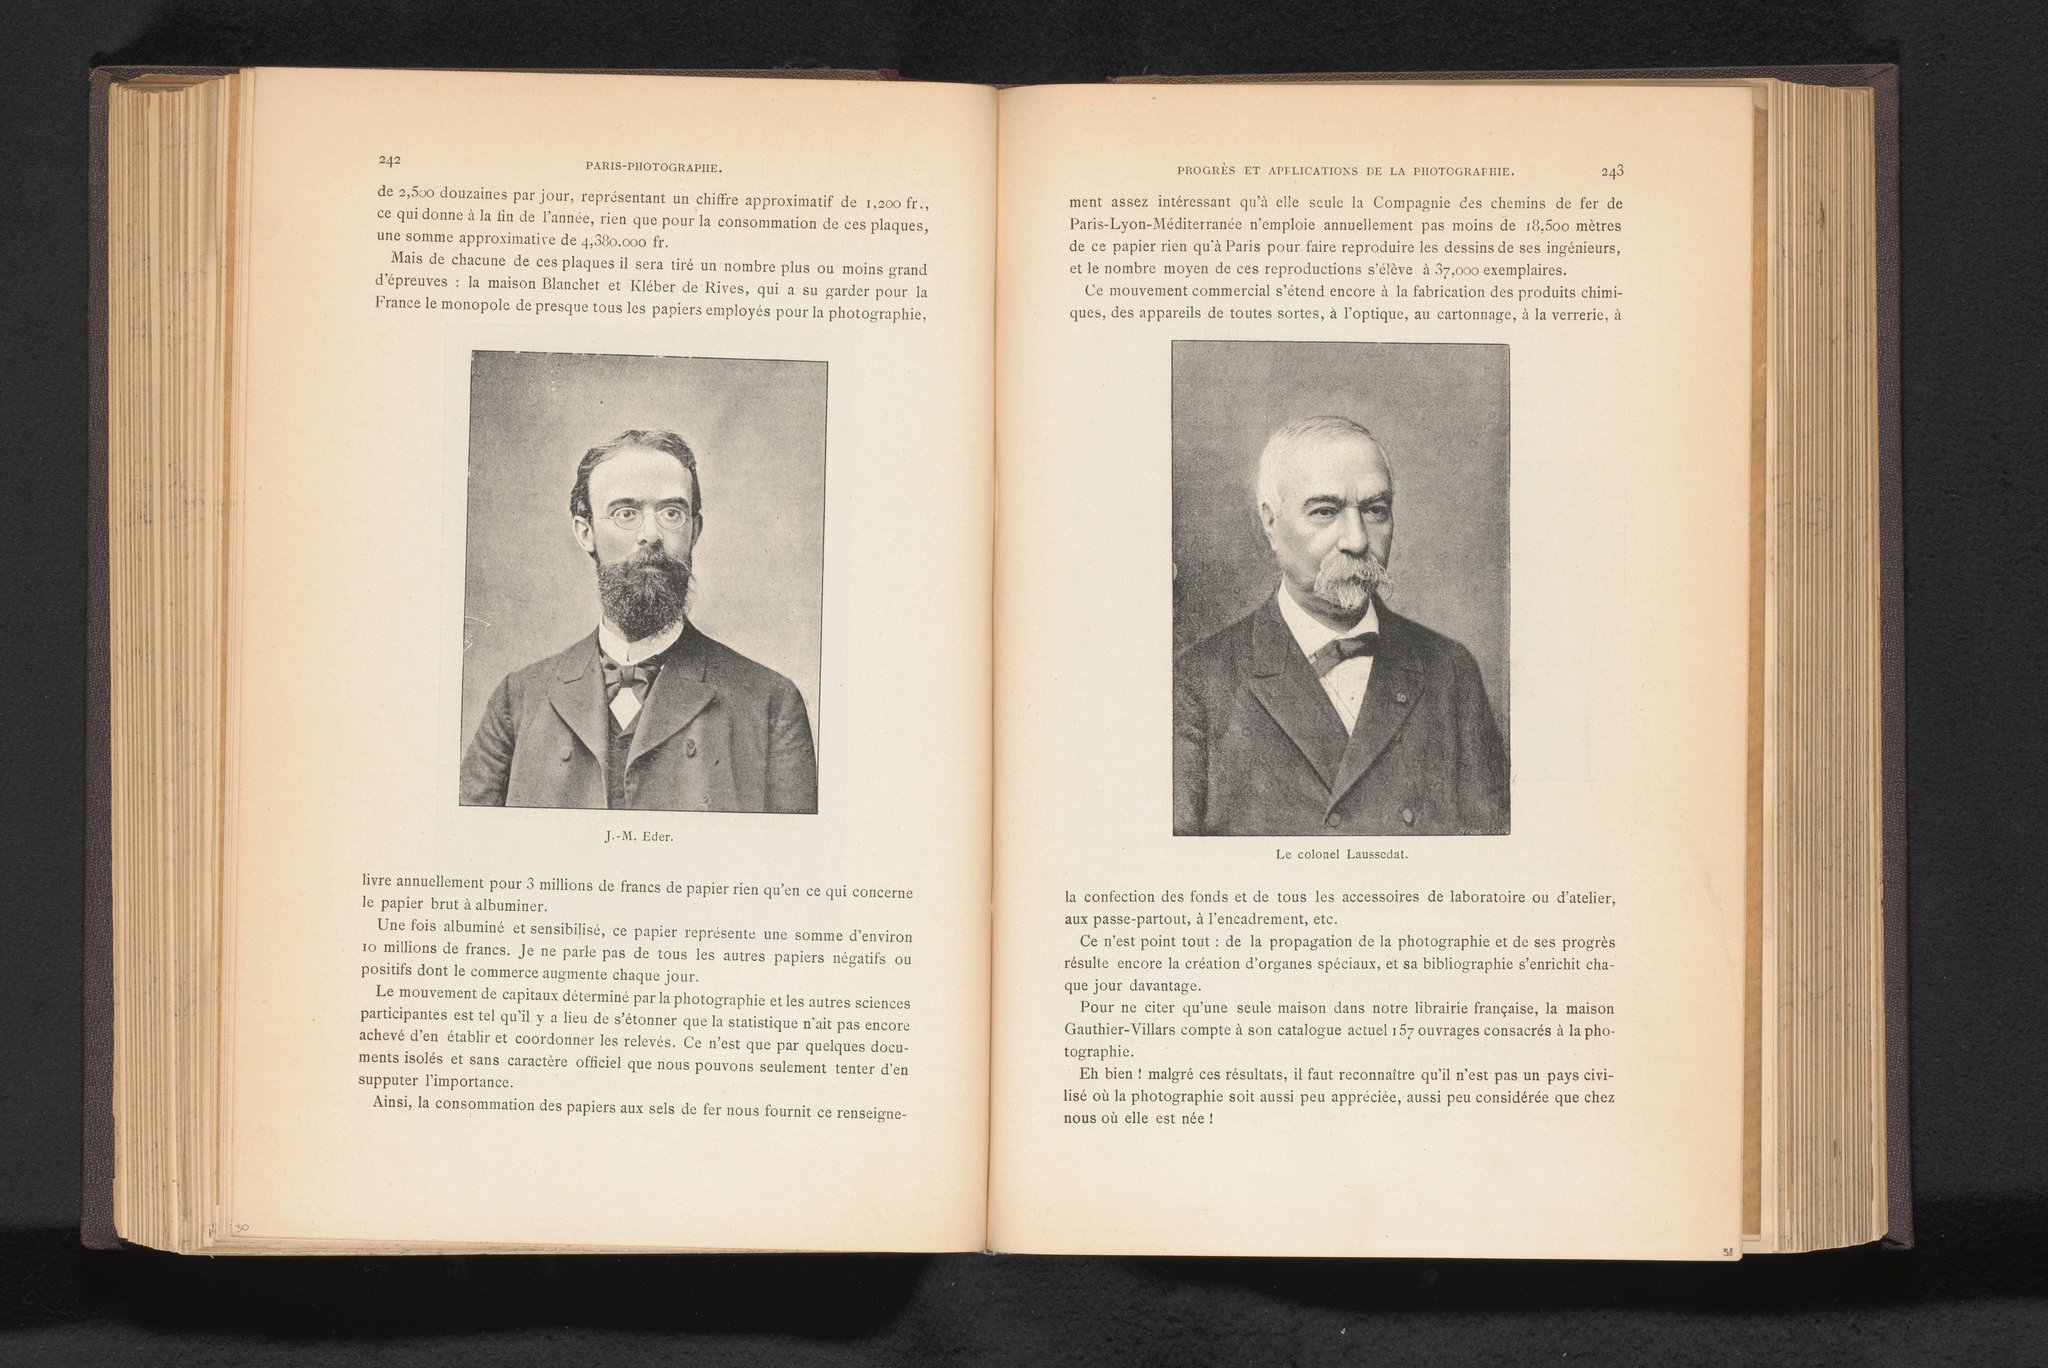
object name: photomechanical print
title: Portret van Josef Maria Eder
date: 1882-1892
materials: paper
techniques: autotype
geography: france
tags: josef maria eder, photographer in non-work situation